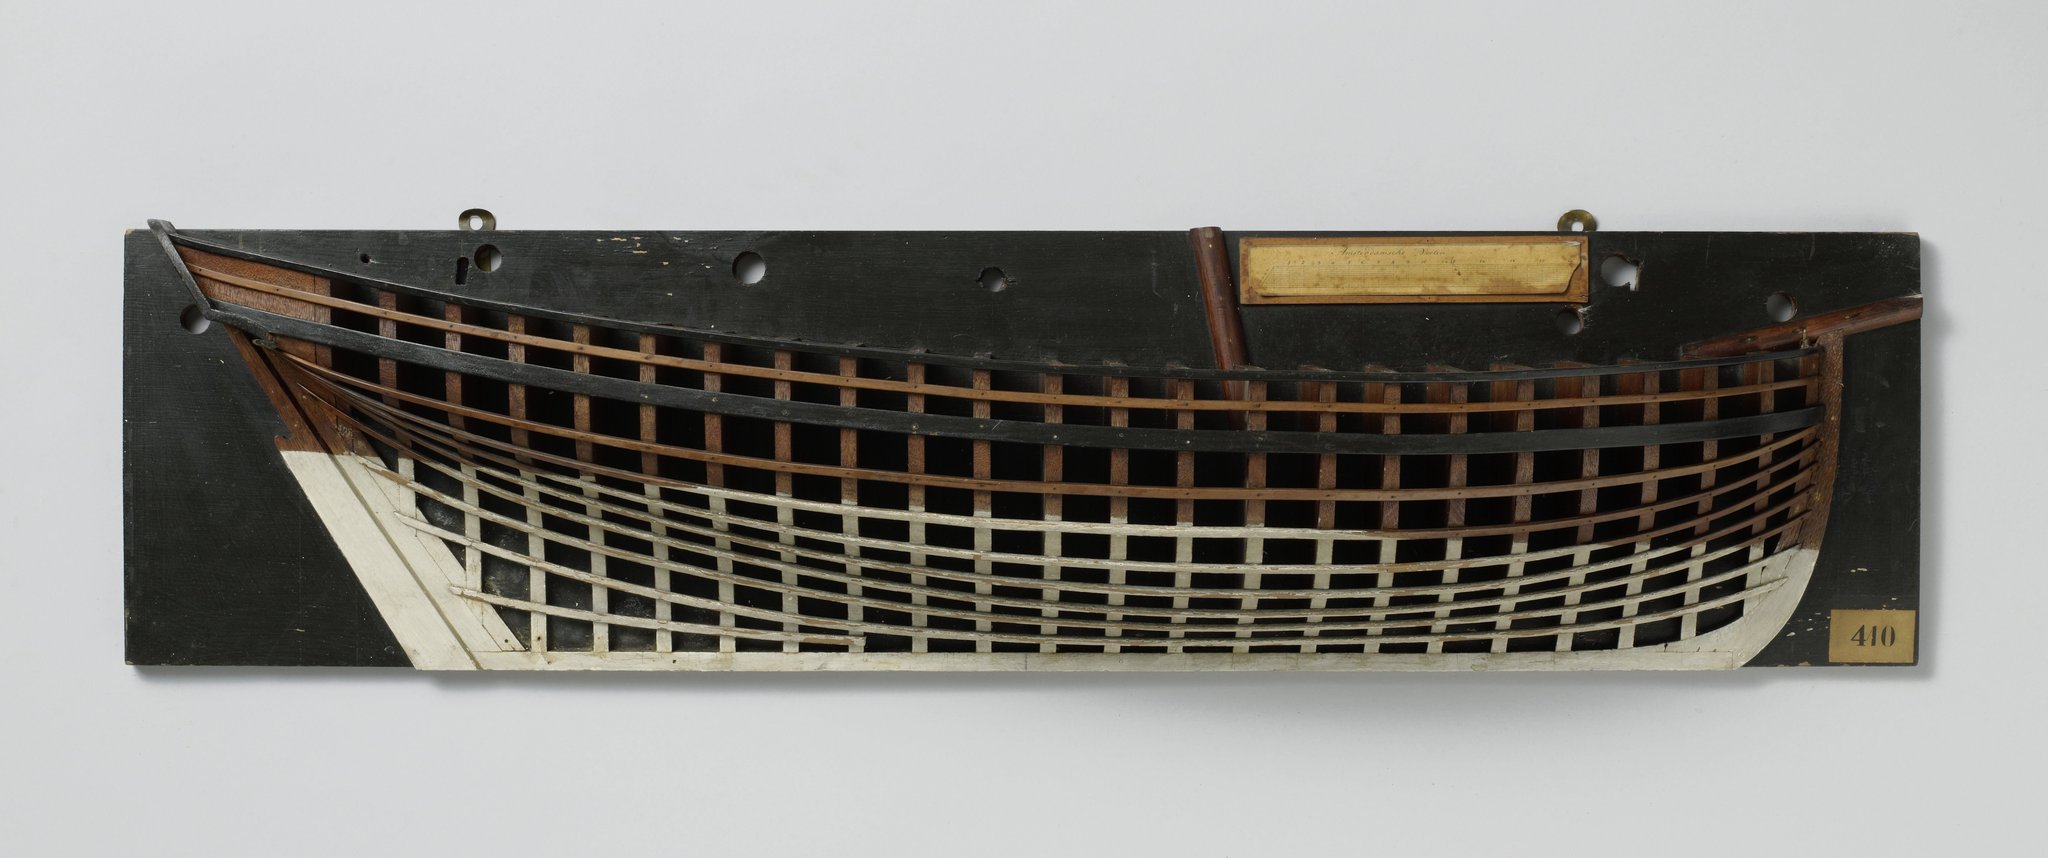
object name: ship model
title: Half Model of a 14-Gun Cutter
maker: Anonymous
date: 1780-1820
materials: wood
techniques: polychromy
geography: netherlands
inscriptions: scale, top centre: paper scale in Amsterdam feet, label, bottom right: ‘410’ former inventory label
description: Gepolychromeerd mallenmodel (stuurboord) van een eenmaster. Gewrongen spiegel, hol wulf, gesloten hek, sterk vallende achtersteven; recht roer met vierkante roerkoning. De zeeg loopt naar achter sterk op, één barkhout en één reehout. Gepiekt rondspant, scherp onderwaterschip, zeer veel stuurlast. Sterk achterover hellende mast.